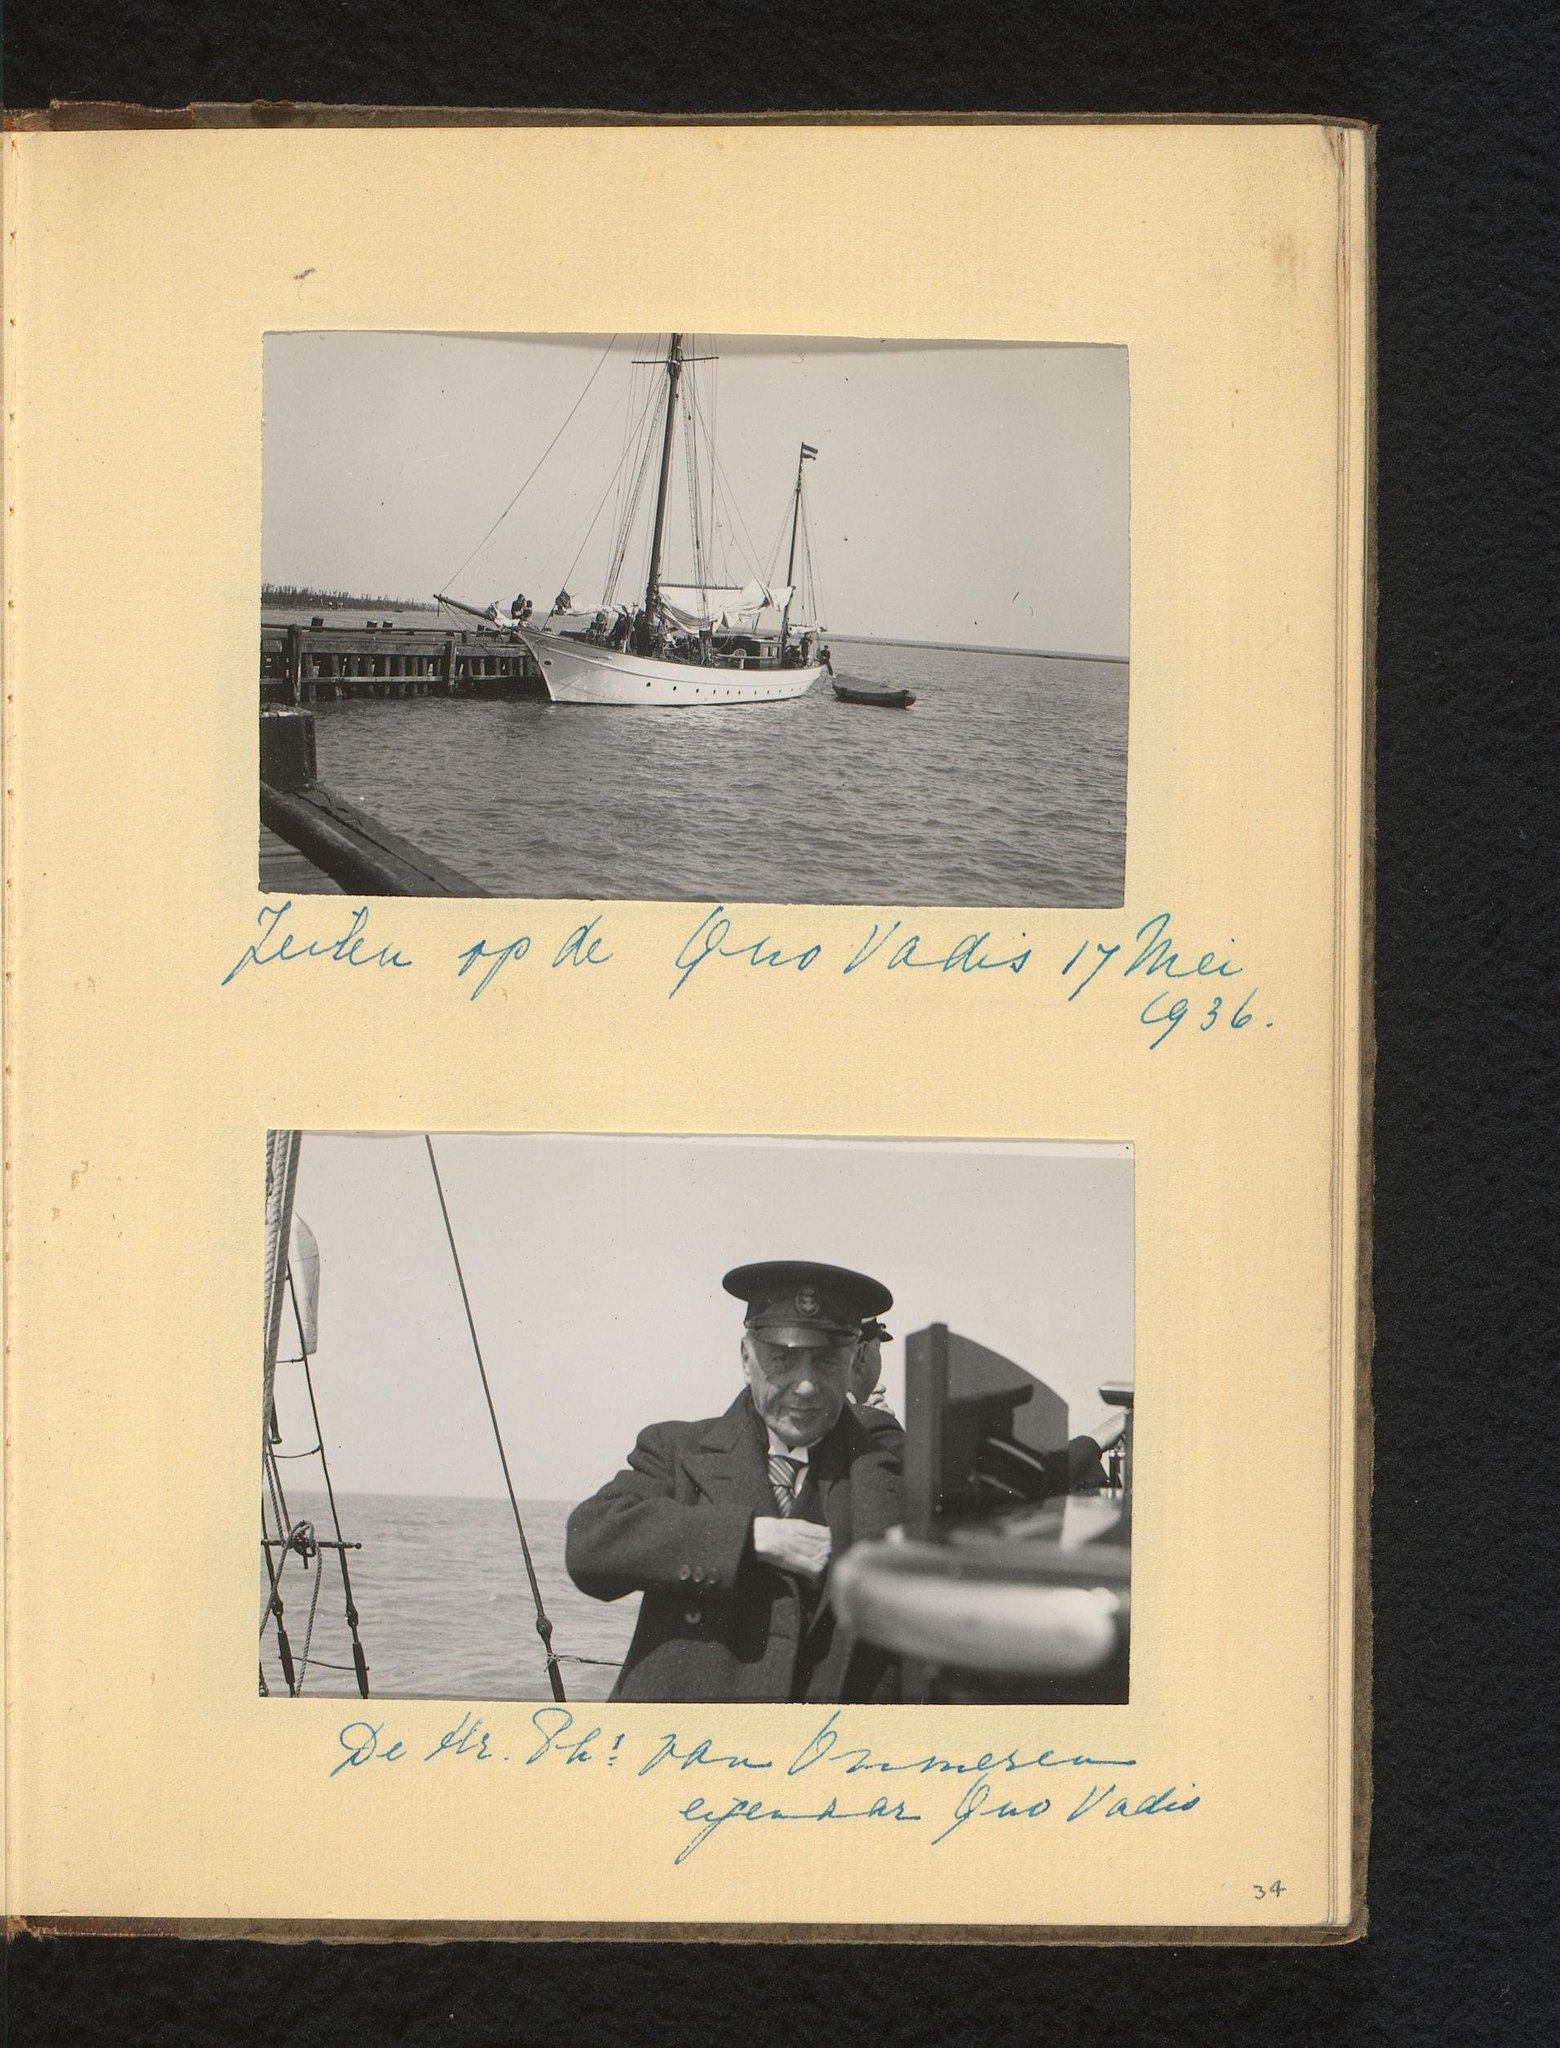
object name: photograph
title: Twee foto's van zeiljacht Quo Vadis en Philippus van Ommeren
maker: Anonymous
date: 1936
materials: paper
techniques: gelatin silver print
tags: rotterdam, crew ~ ship, sailing-ship, sailing-boat, historical persons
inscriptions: inscription: ‘De Hr. Phs. van Ommeren/ eigenaar Quo Vadis’, inscription: ‘Zeilen op de Quo Vadis 17 Mei/ 1936’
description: Deze foto's maken deel uit van een album.